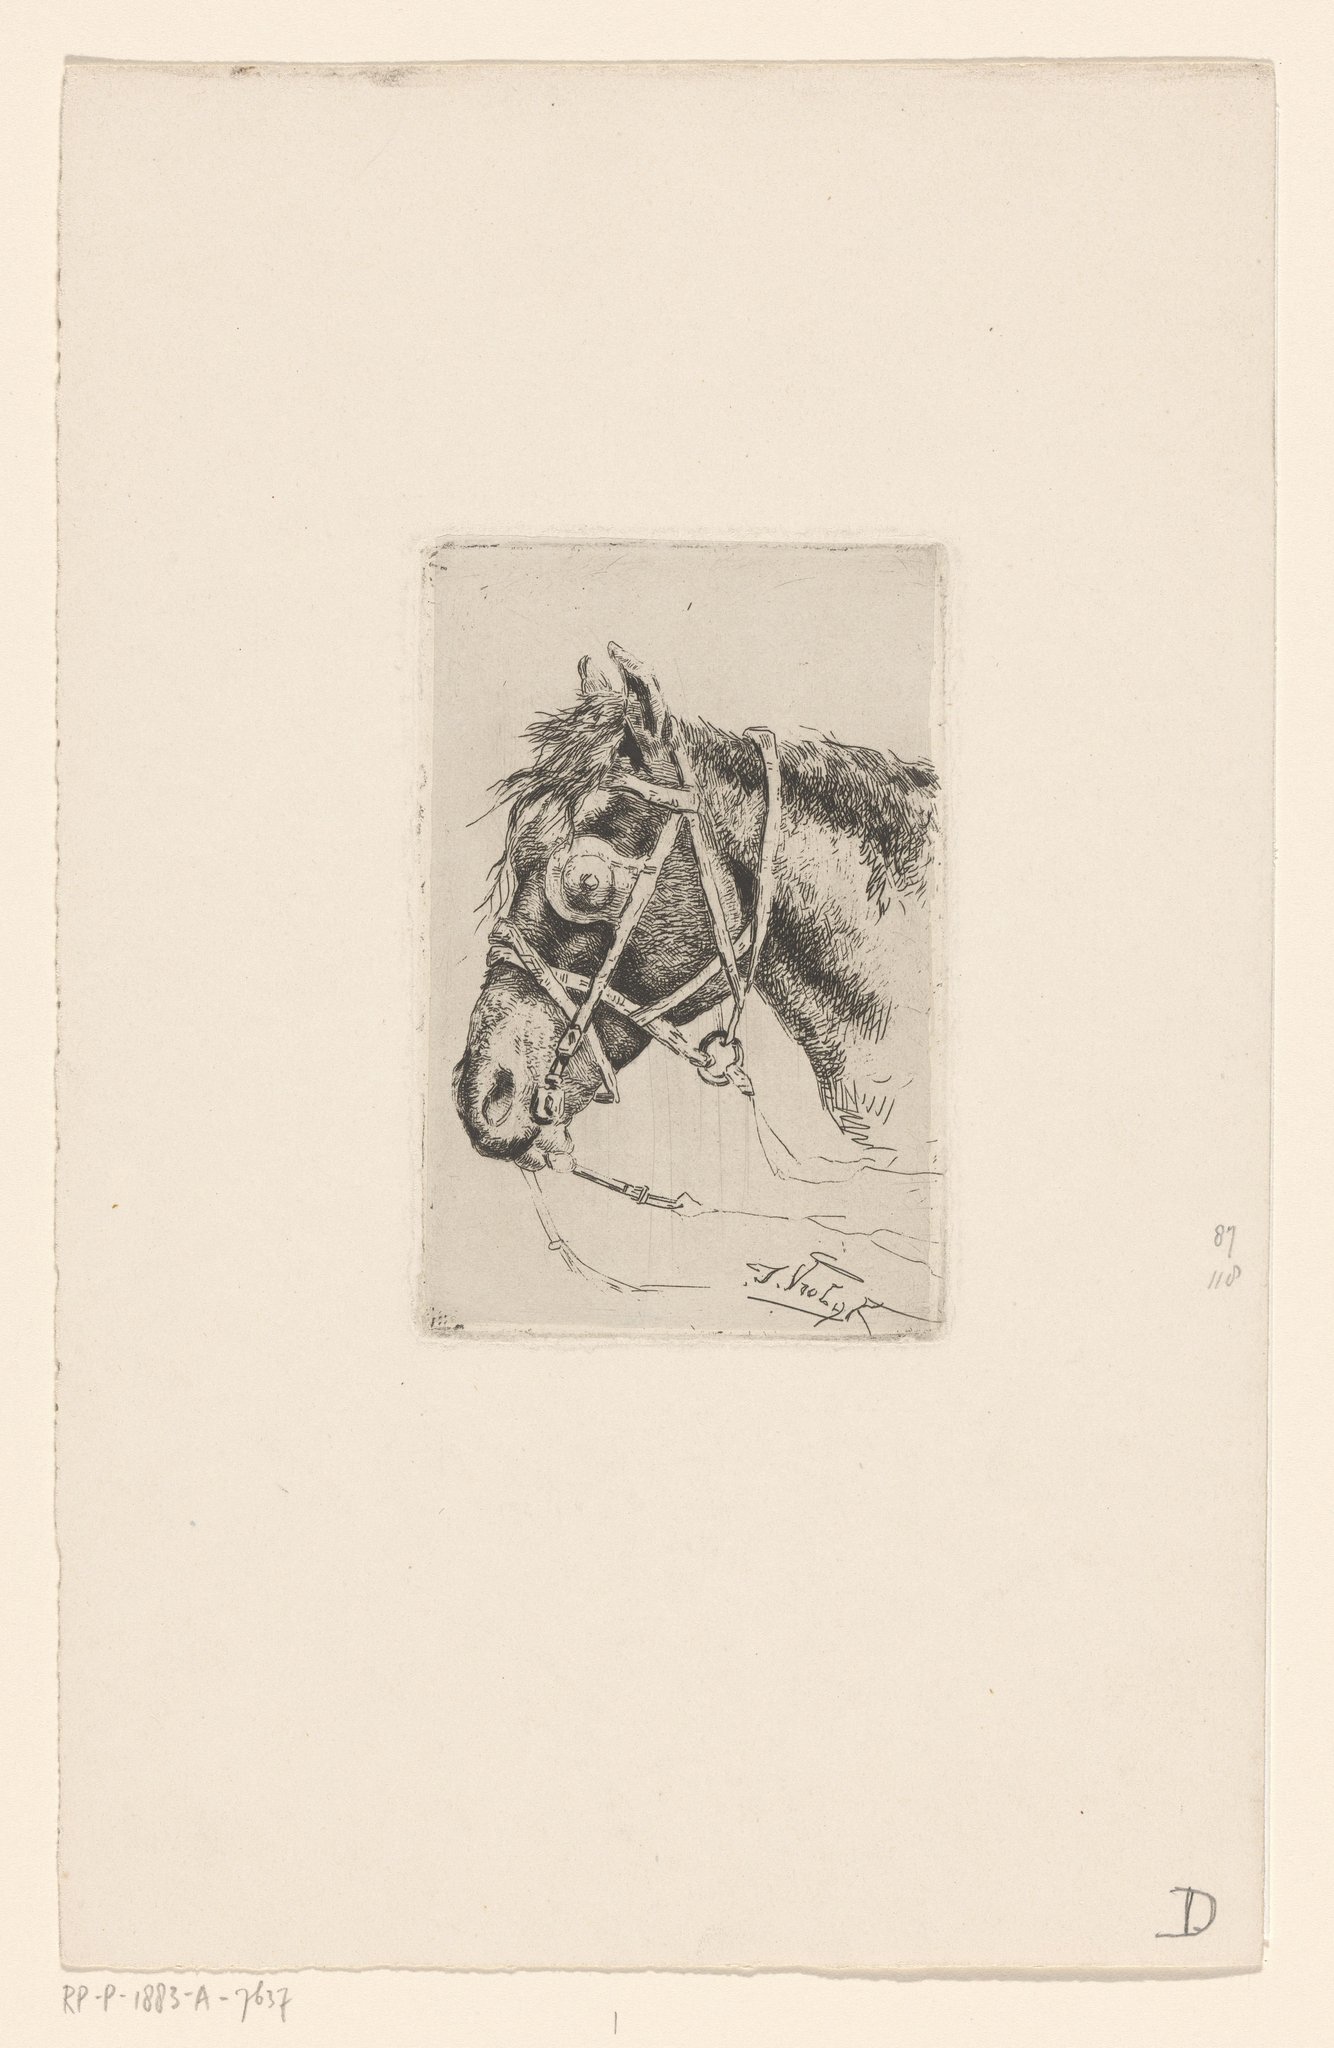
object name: print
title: Hoofd van een paard, met hoofdstel en oogkleppen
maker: jan vrolijk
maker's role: draughtsman, painter, print maker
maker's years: 1846-1894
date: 1856-1883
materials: paper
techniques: etching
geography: the hague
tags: horse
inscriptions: collector's mark: Lugt 2228